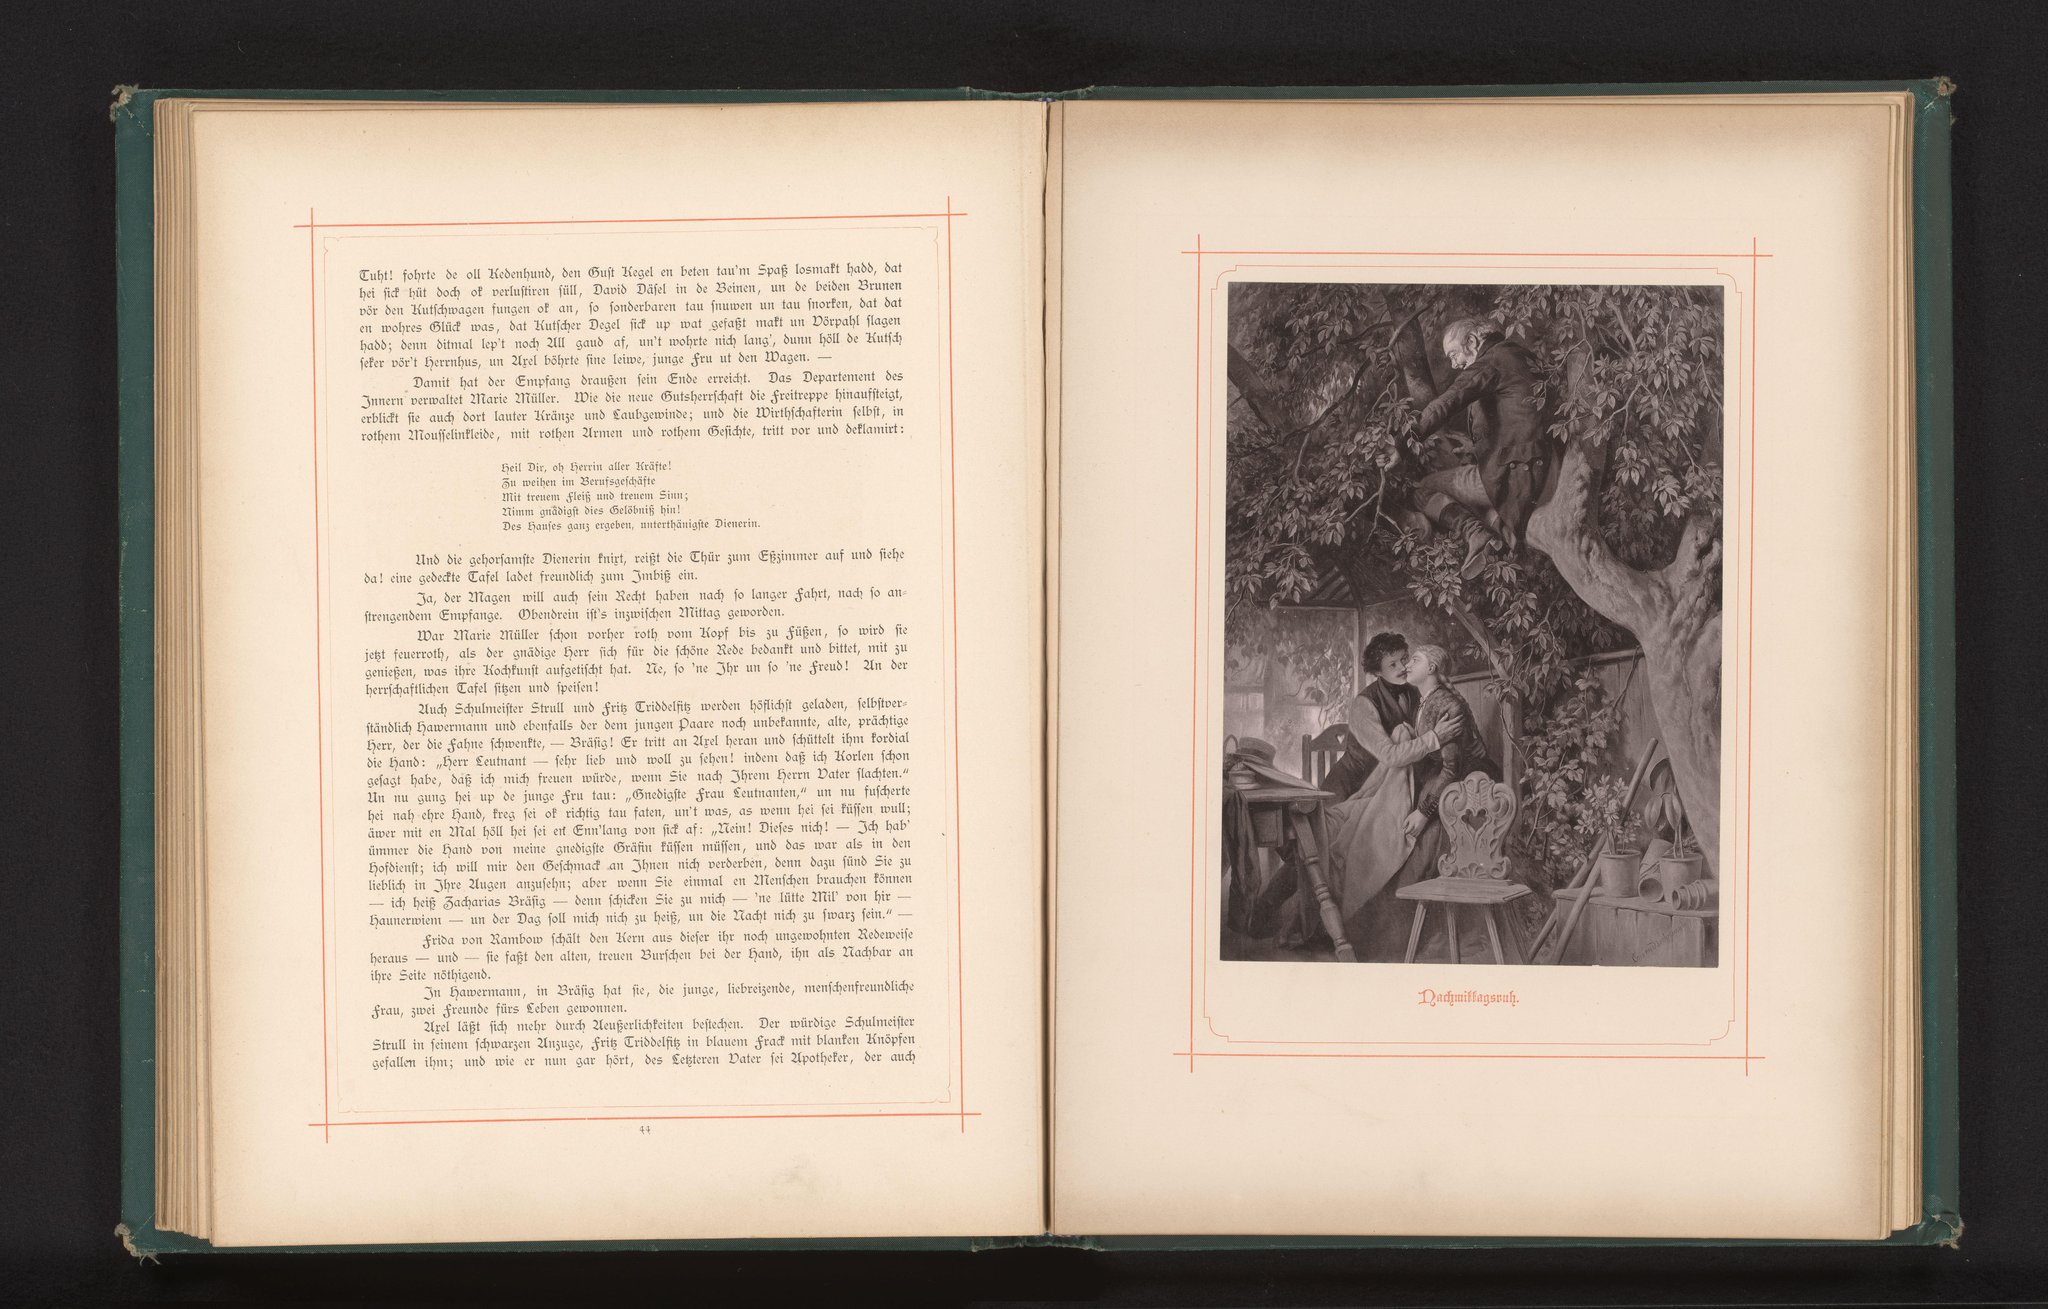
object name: photomechanical print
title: Nachmittagsruh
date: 1874-1884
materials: paper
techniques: photograph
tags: trees, garden, picture, painting, couple of lovers